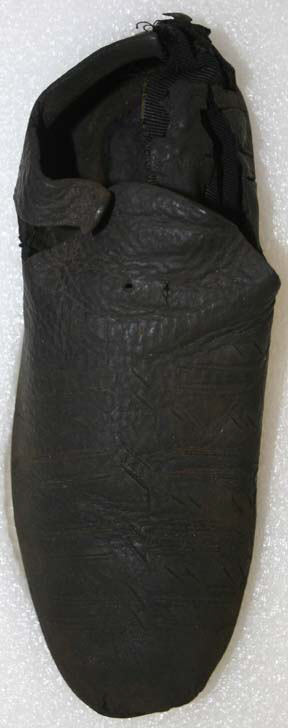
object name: shoe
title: Shoes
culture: british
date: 1601-1700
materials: leather